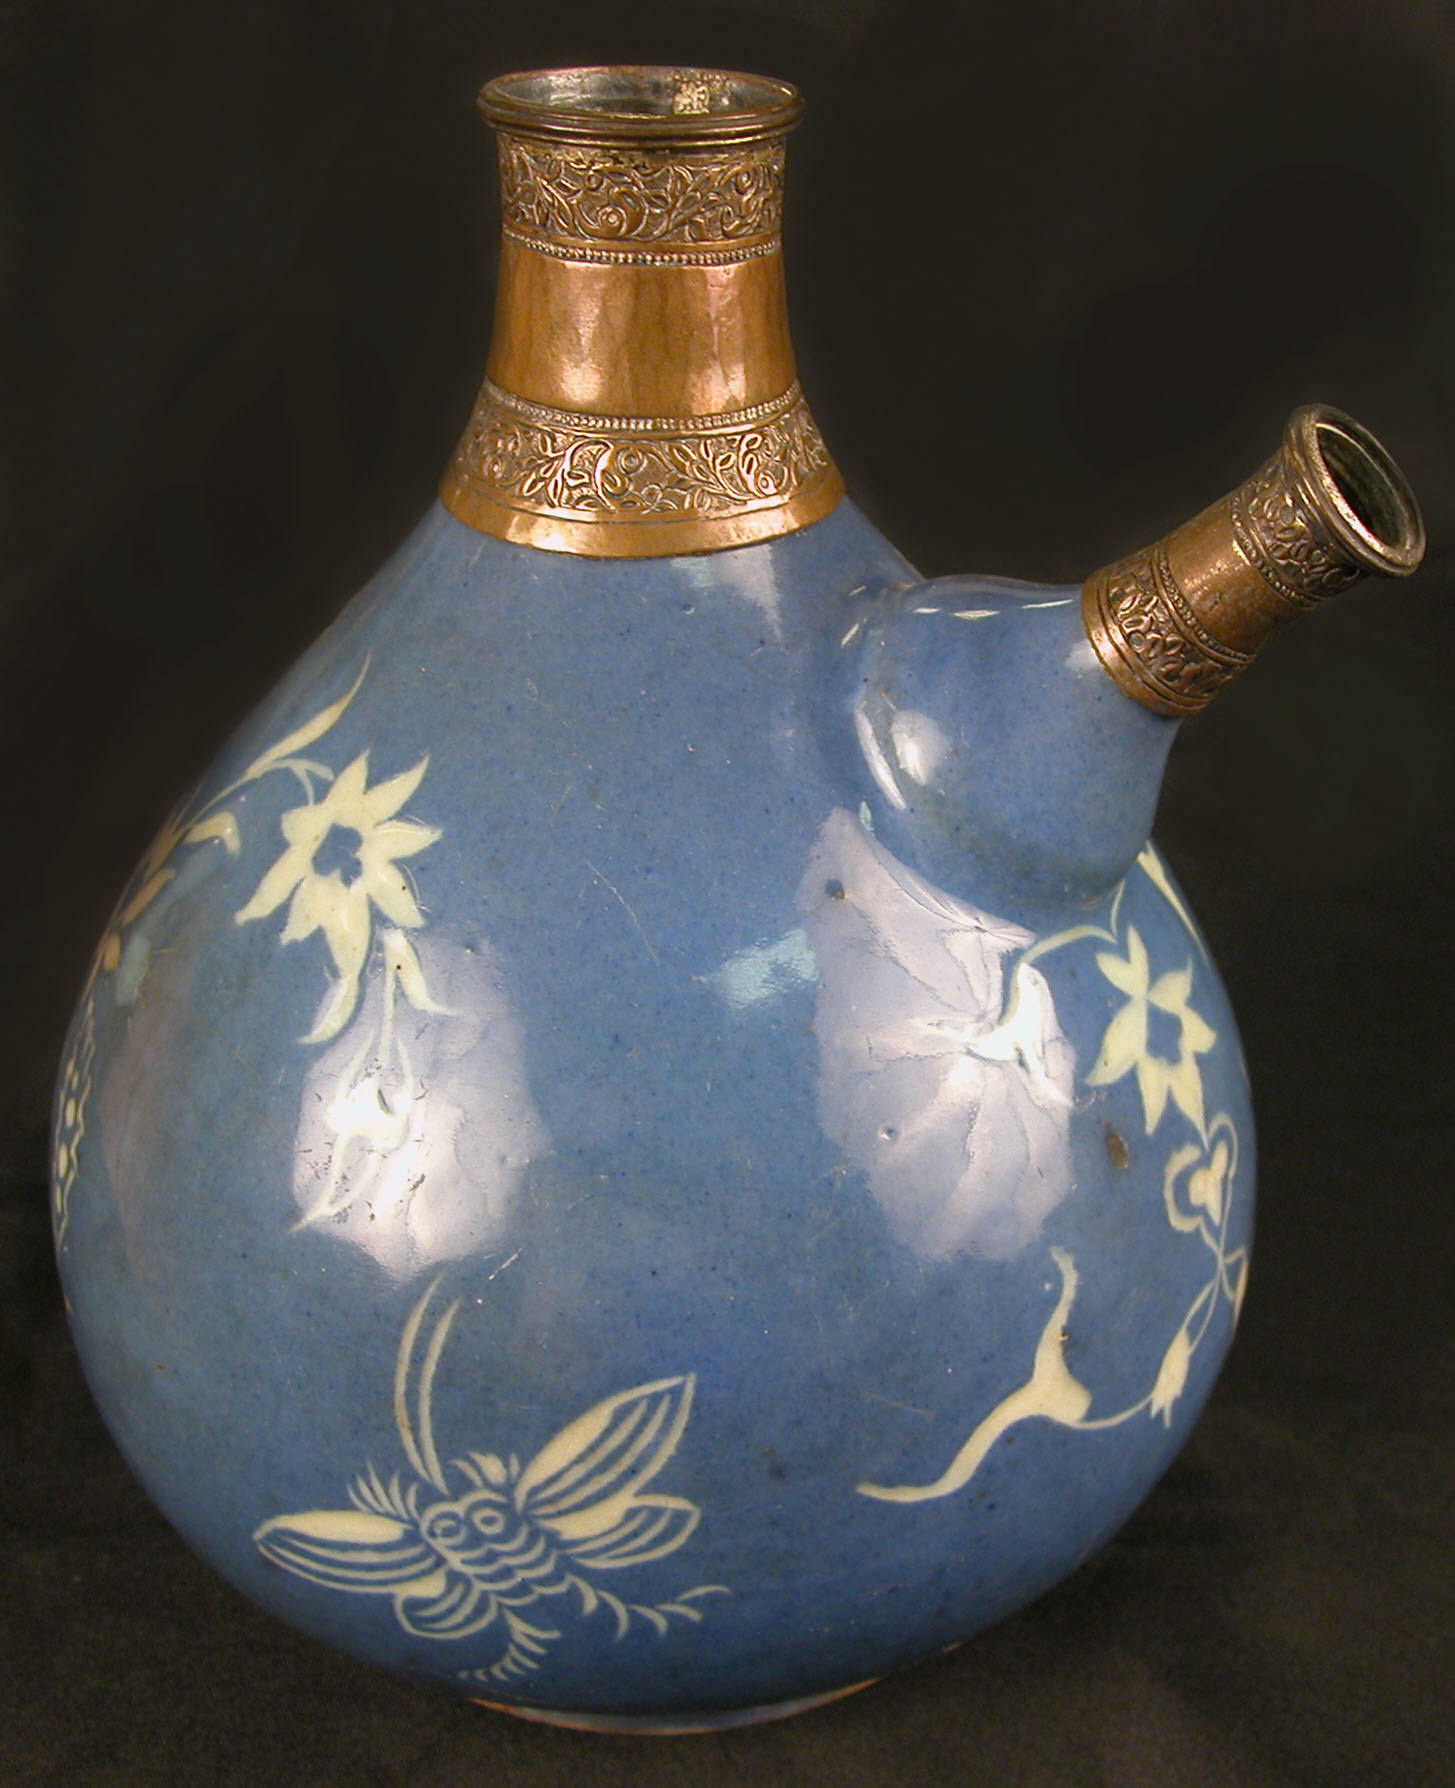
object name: water pipe base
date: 1601-1700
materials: copper, glaze, stonepaste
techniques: incising, painting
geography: iran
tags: insects,flowers